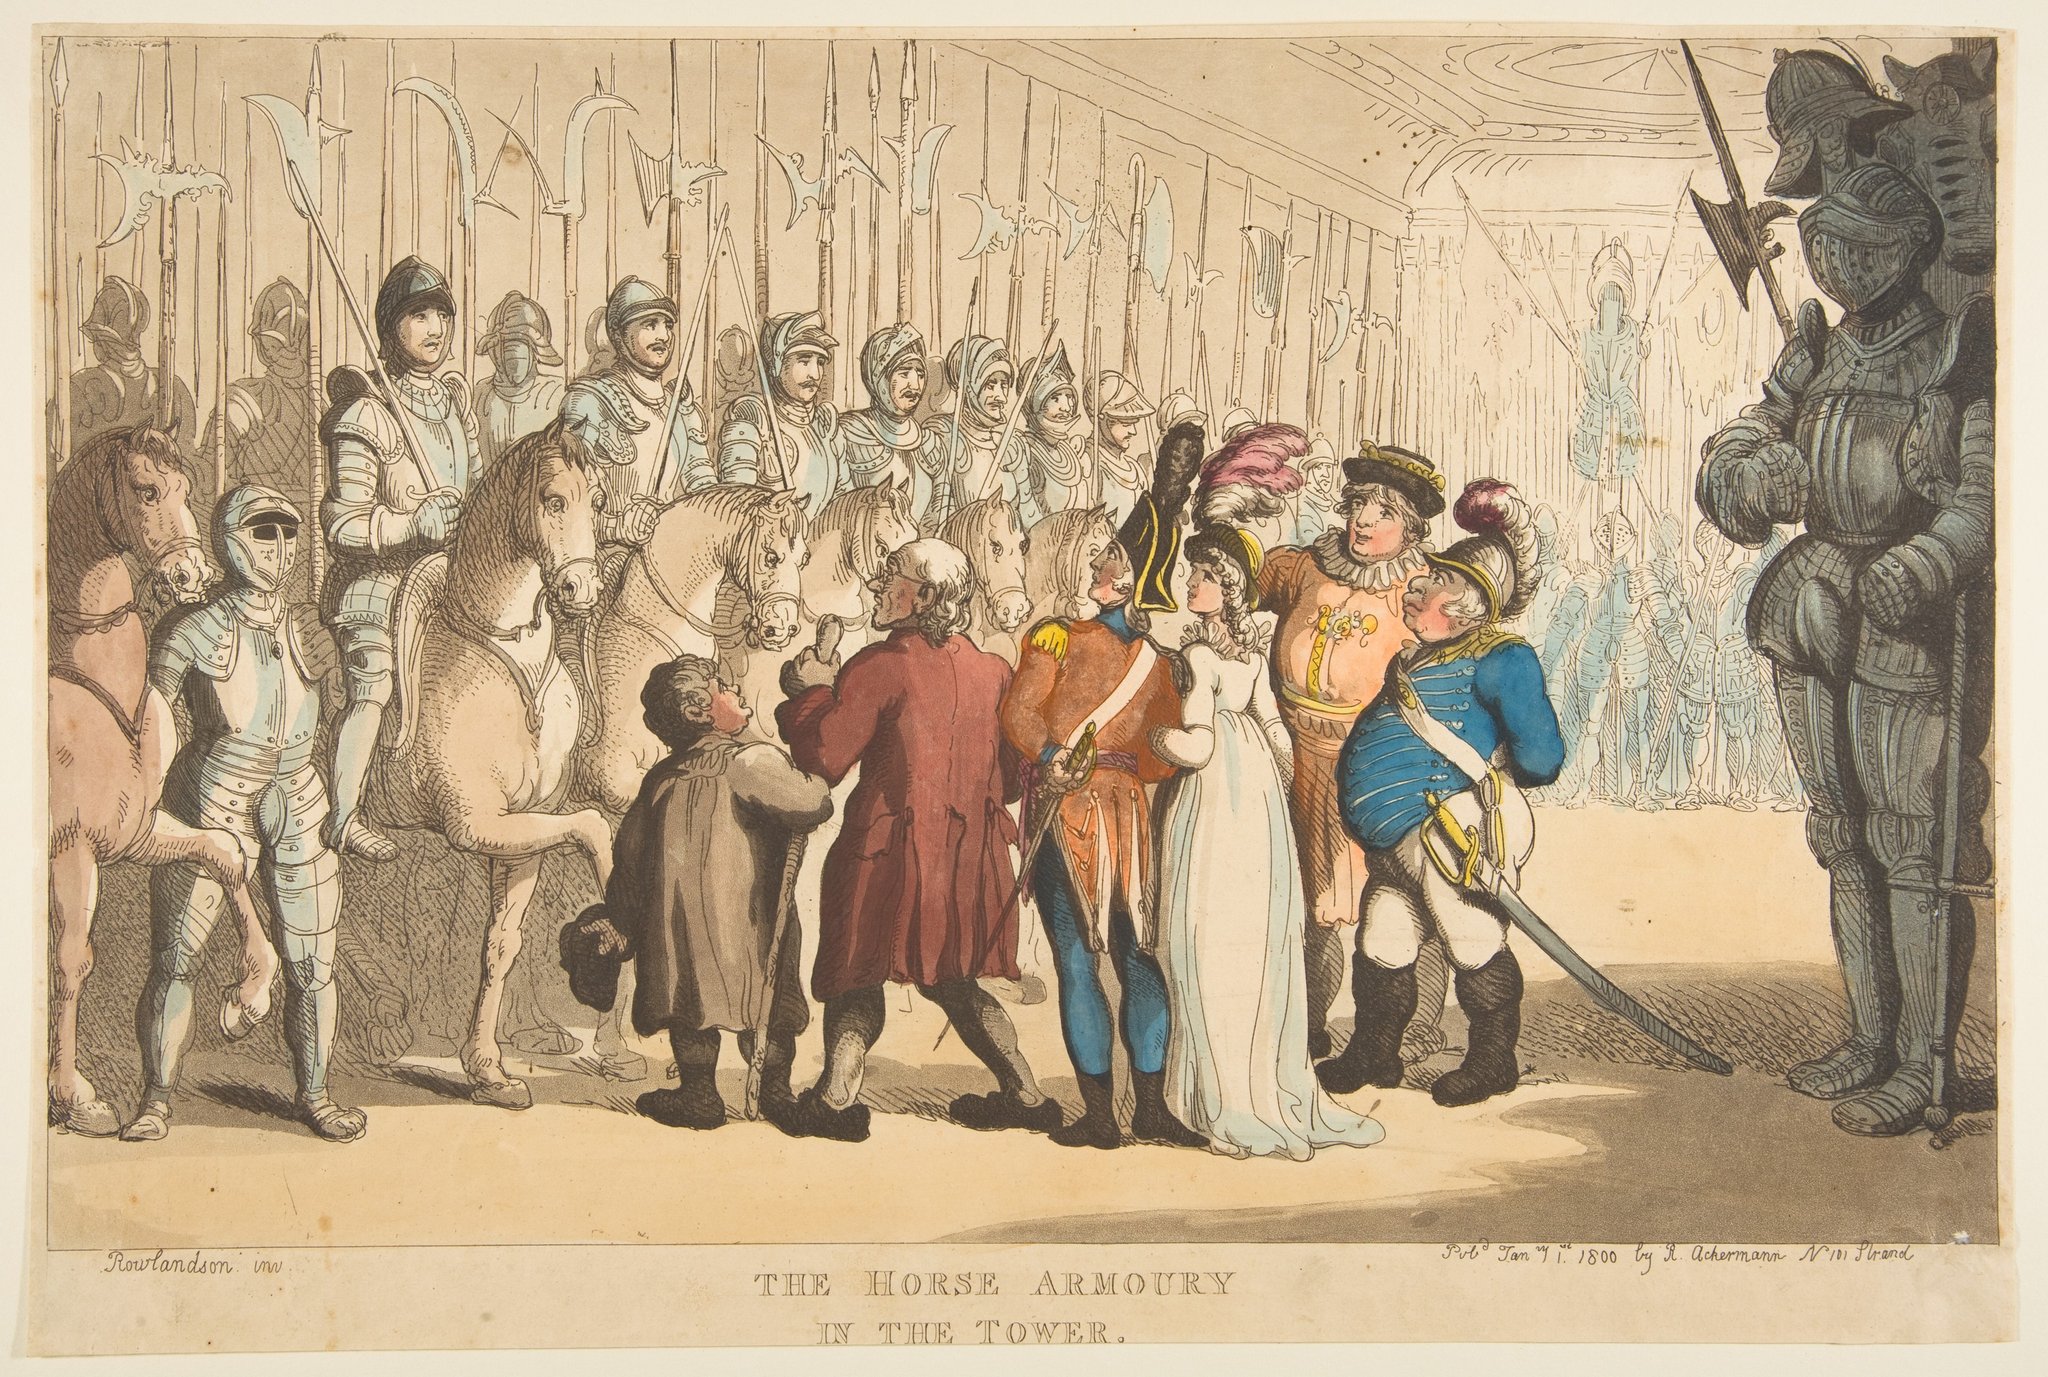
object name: print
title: The Horse Armoury in the Tower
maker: thomas rowlandson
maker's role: artist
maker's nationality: british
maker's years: 1757-1827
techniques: etching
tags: armor,weapons,boys,men,horses,crowd